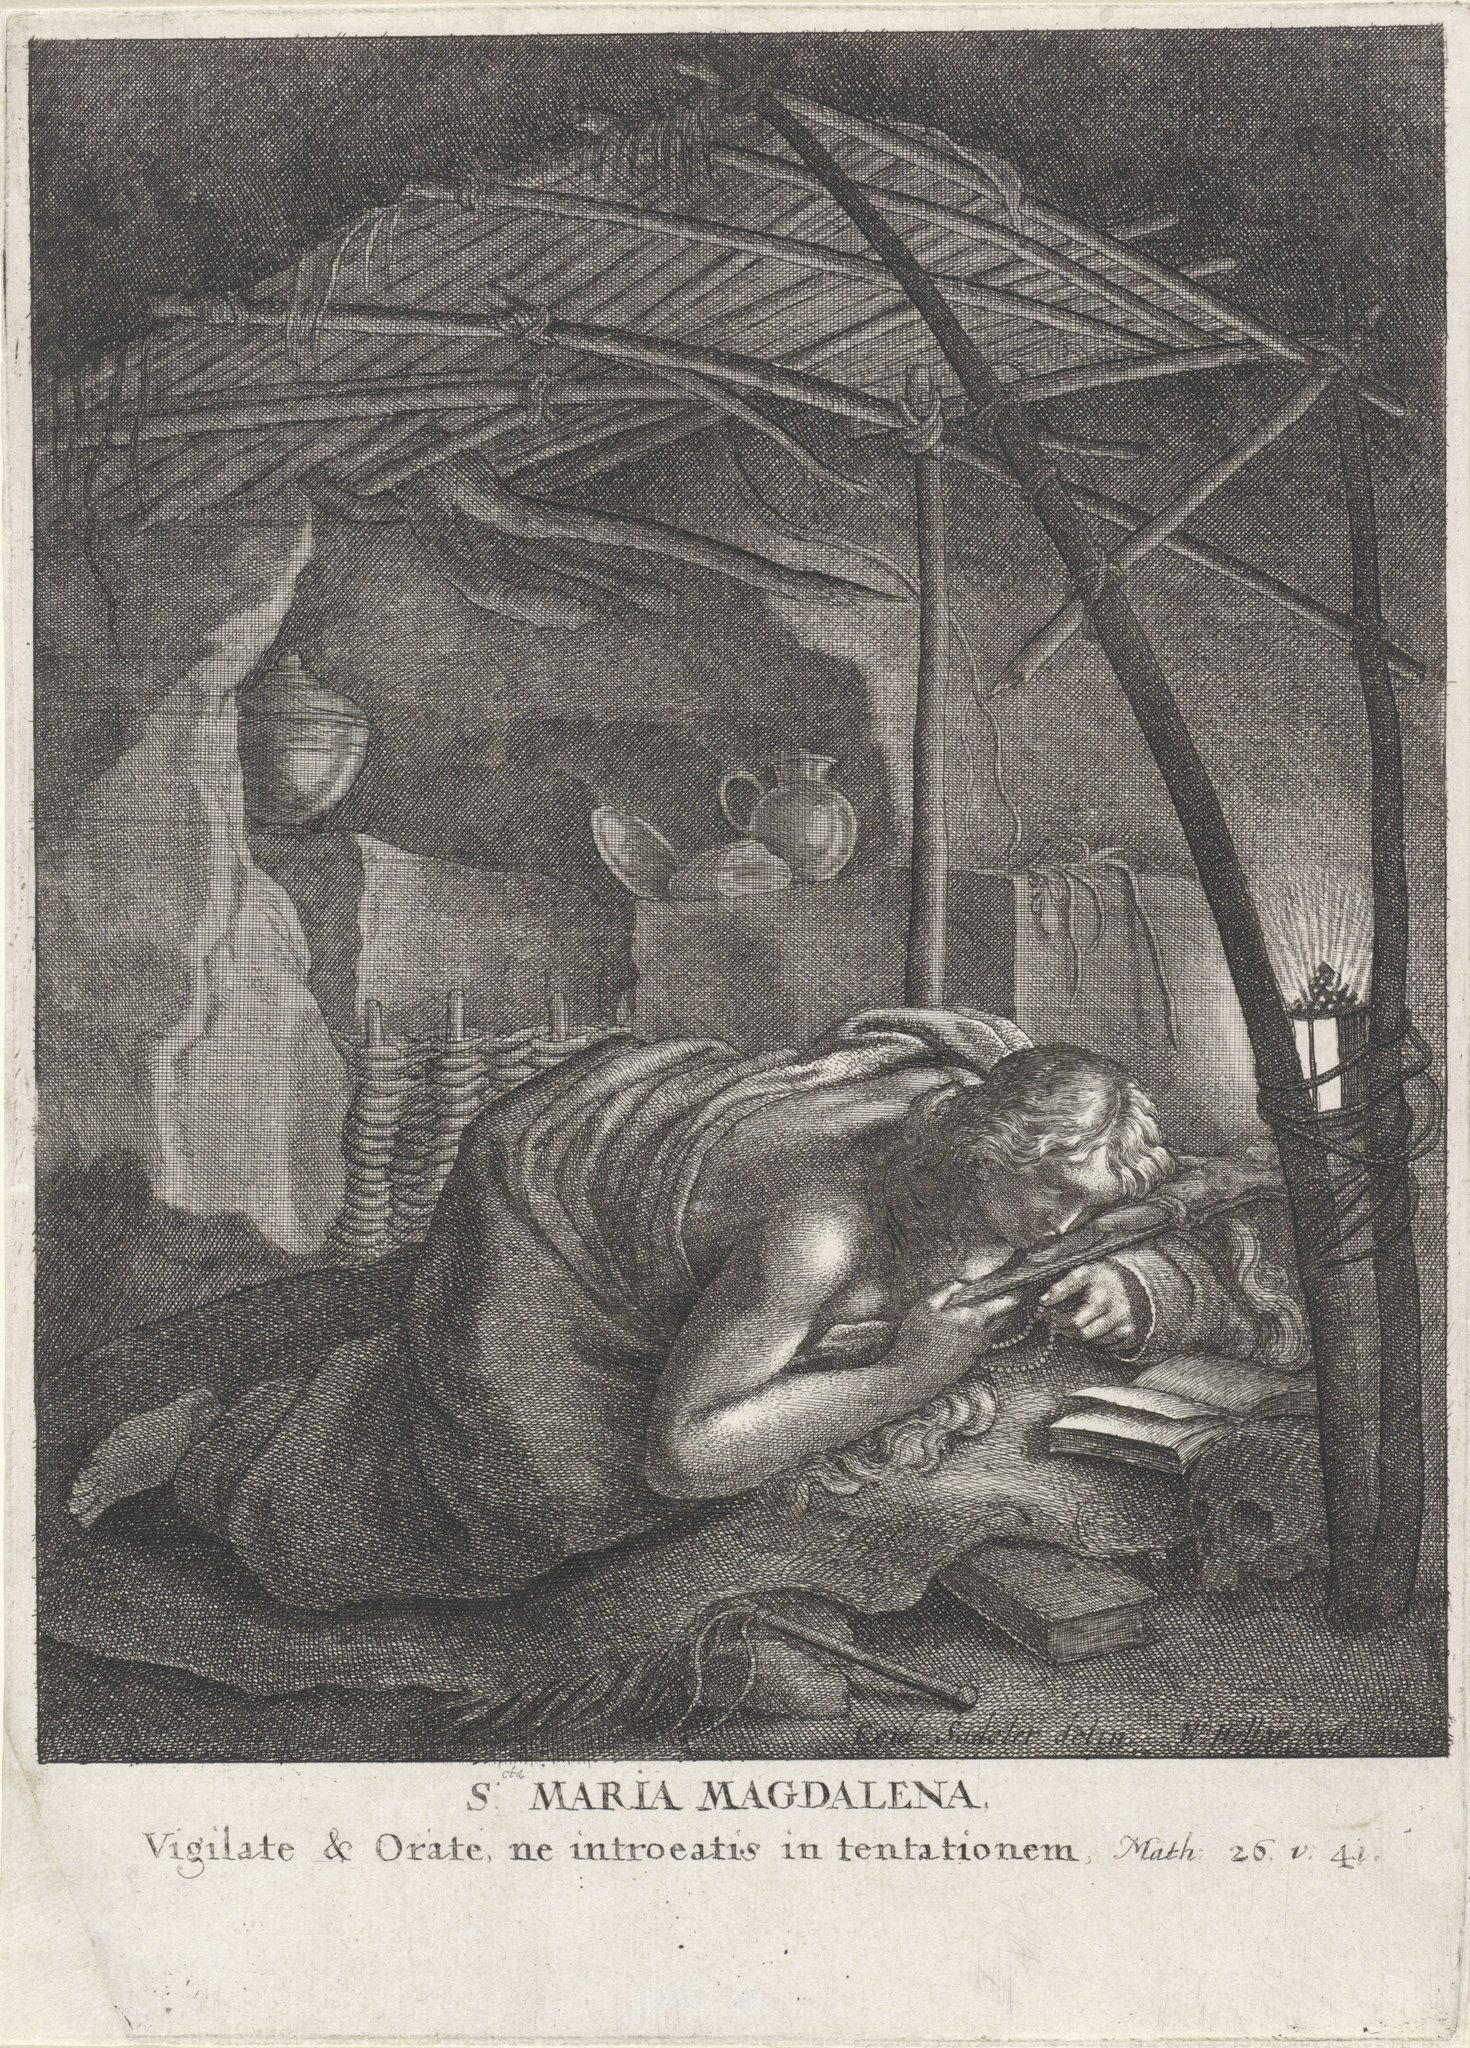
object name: print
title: Scta Maria Magdalena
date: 1646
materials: paper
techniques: etching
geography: antwerp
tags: the penitent st. mary magdalene (often before a cave, possibly at la sainte-baume hill): her long hair covers her (naked) body, she reads, meditates or raises her tear-filled eyes towards heaven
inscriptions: collector's mark: Lugt 240